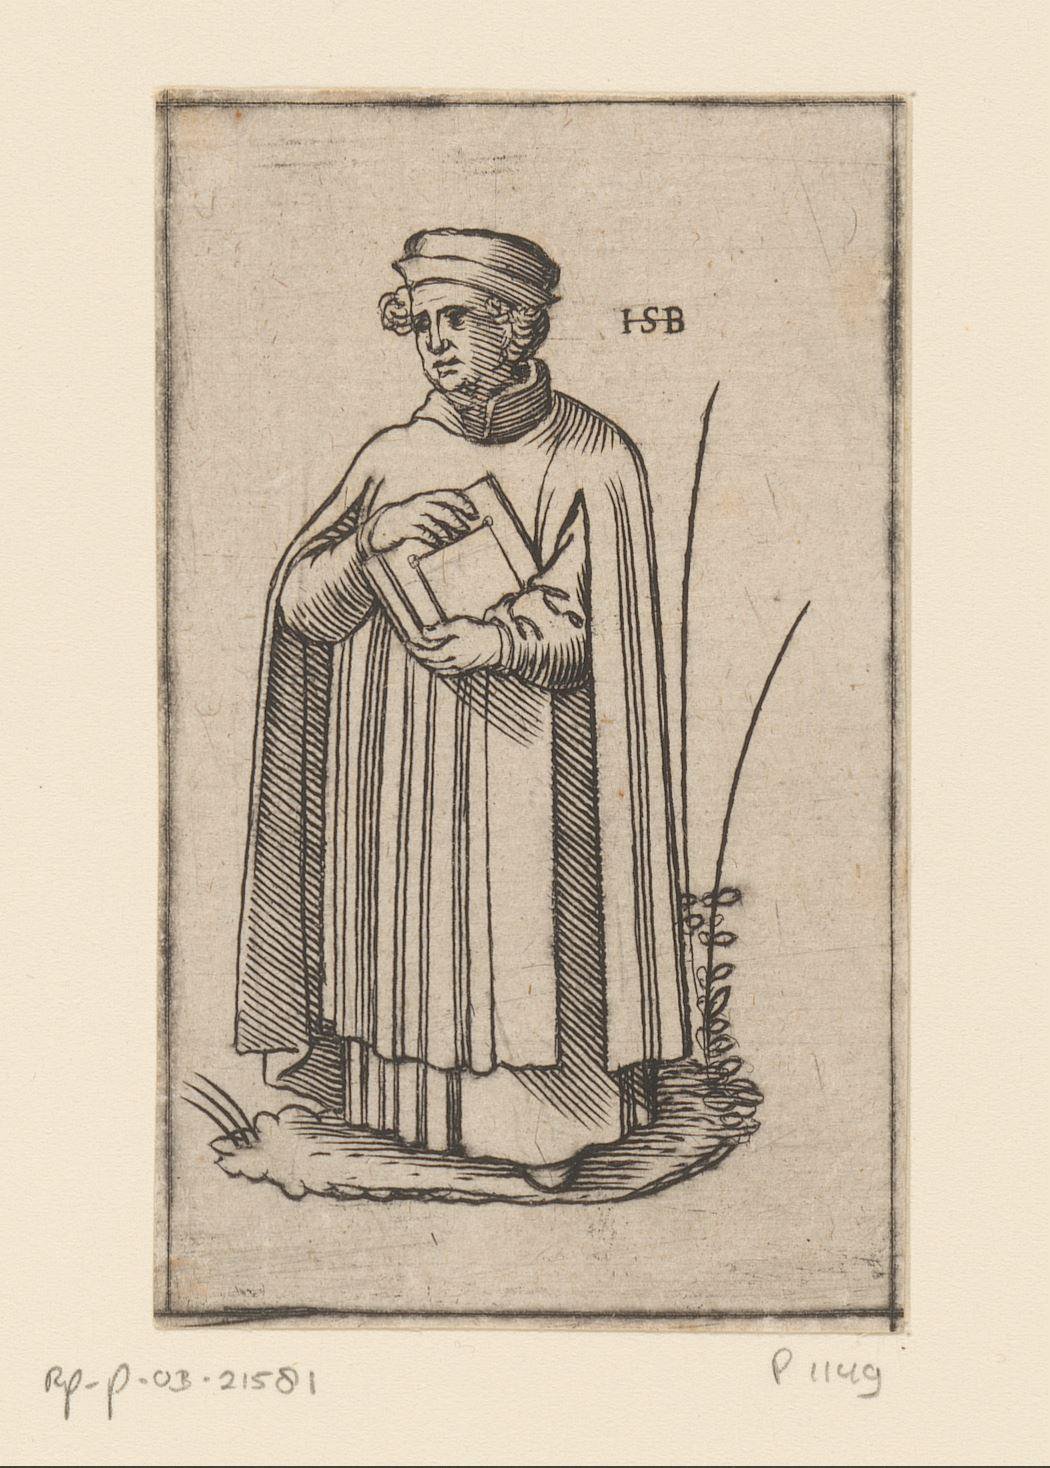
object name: print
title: Kostuums van geestelijken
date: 1526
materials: paper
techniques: engraving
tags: liturgical vestments, canonicals, monastic orders, monastic life ~ roman catholic church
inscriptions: collector's mark: Lugt 2228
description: Onderdeel van een serie van 28 gegraveerde kopieën in de andere richting naar Hans Sebald Behams "Das Papstthum mit seinen Gliedern", 1526.